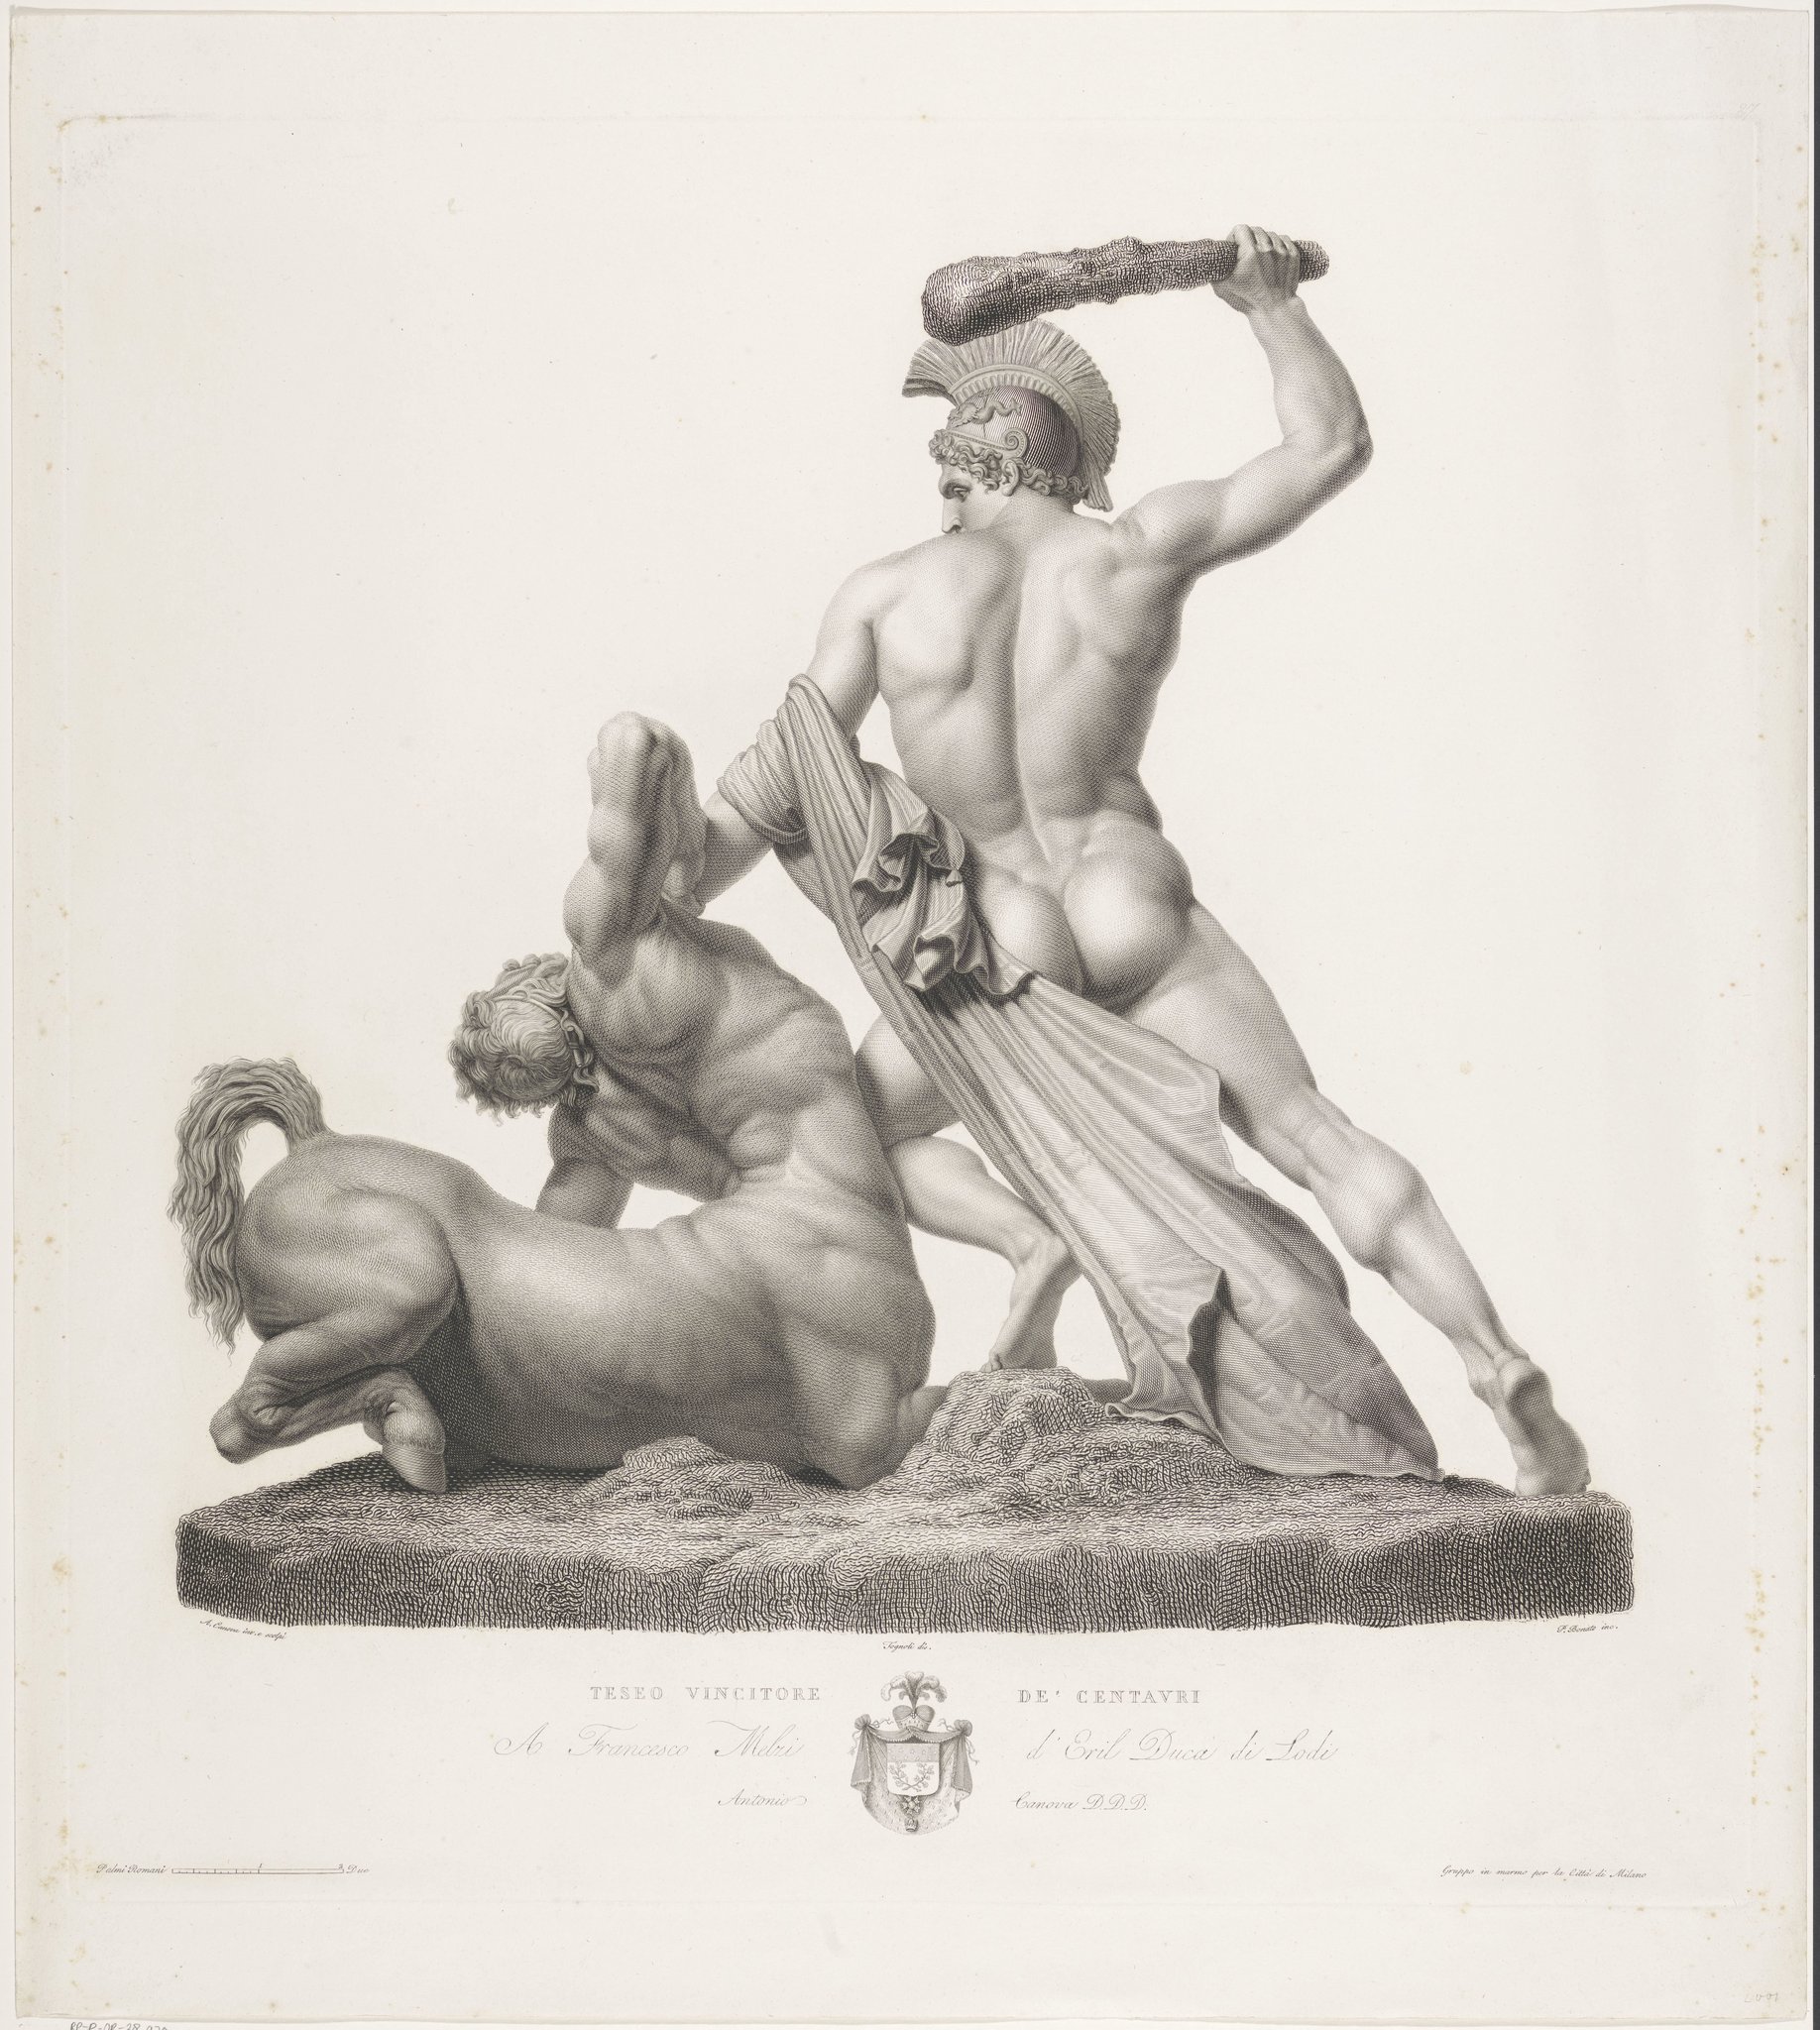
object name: print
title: Sculpturen van Antonio Canova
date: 1775-1827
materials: paper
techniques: engraving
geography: italy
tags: centaurs, piece of sculpture, reproduction of a piece of sculpture, aggressive, unfriendly activities and relationships of theseus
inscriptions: collector's mark: Lugt 12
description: Deze prent maakt deel uit van een reeks van onbekende omvang met voorstellingen van sculpturen van Antonio Canova door verschillende prentmakers naar tekeningen van Giovanni Tognolli. Het beeld van Canova bevindt zich in het Kunsthistorisches Museum in Wenen.